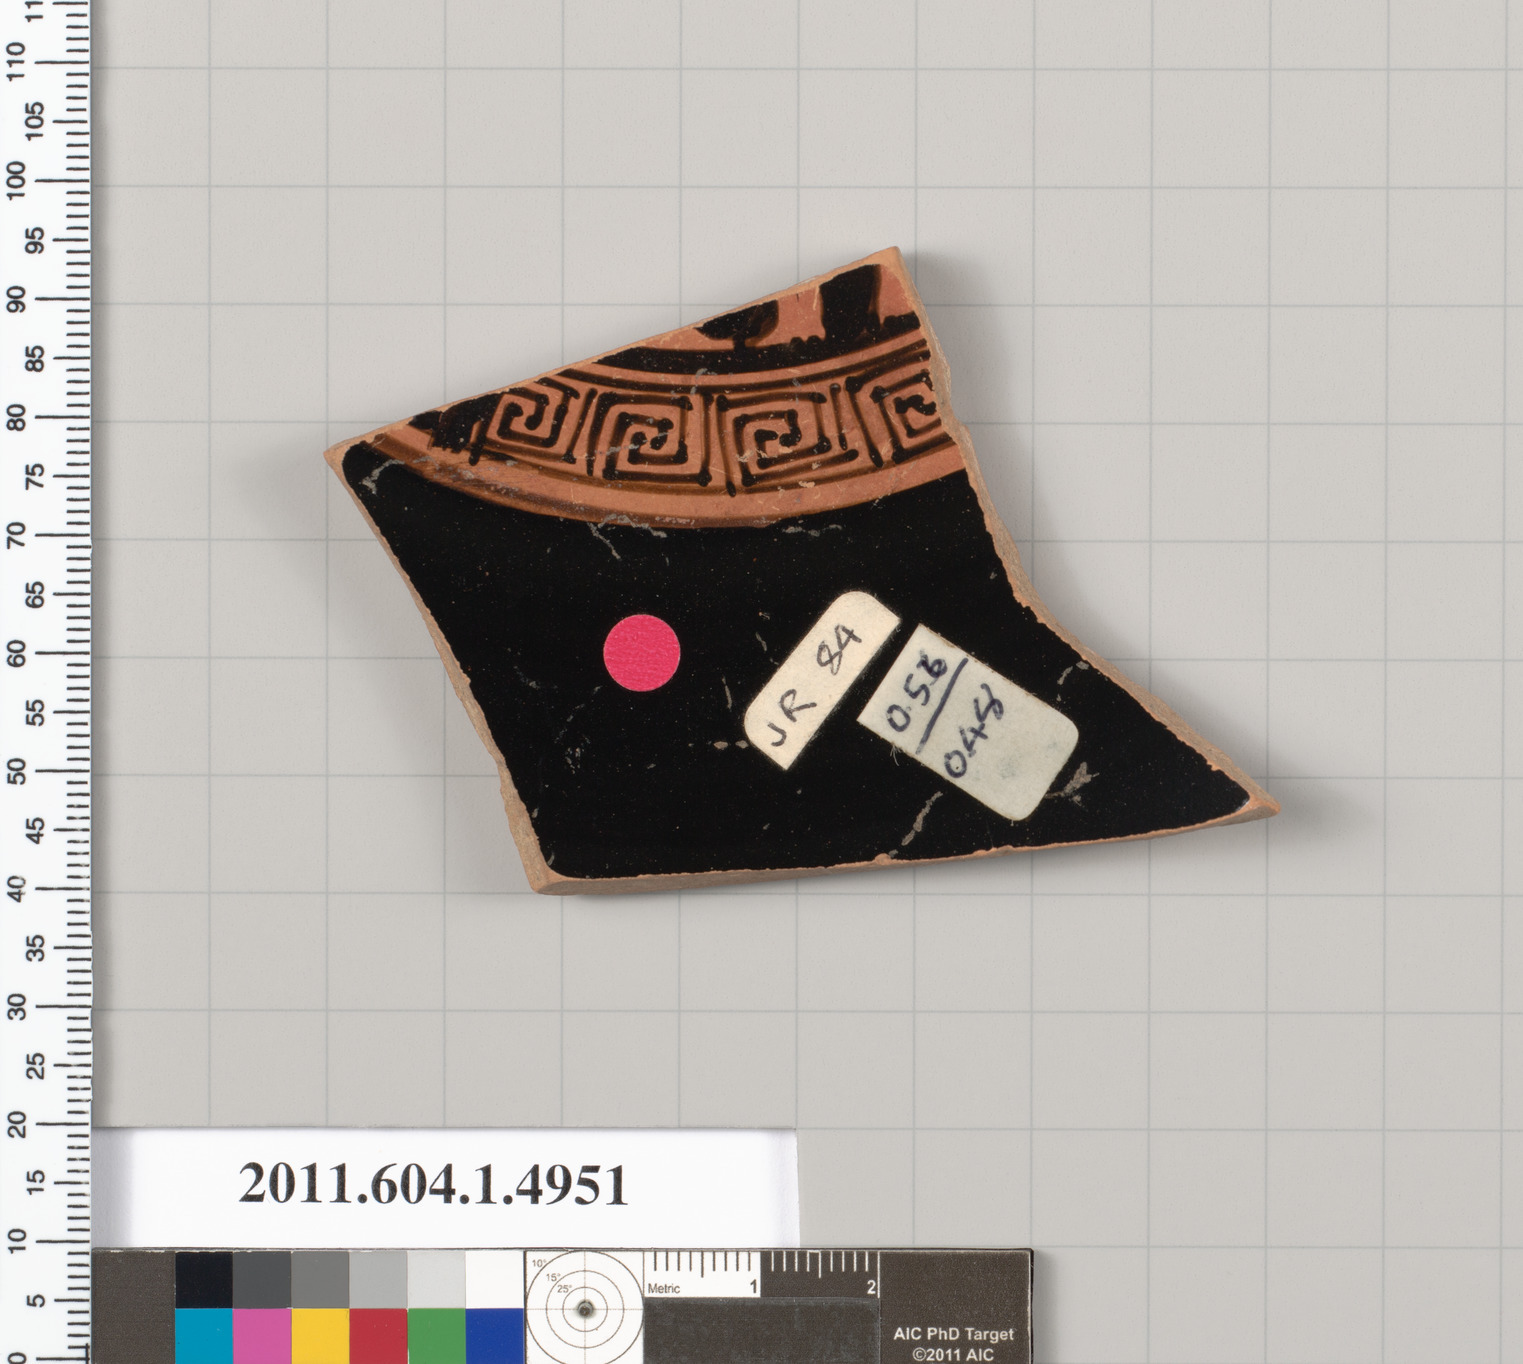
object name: kylix fragment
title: Terracotta fragment of a kylix (drinking cup)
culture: greek, attic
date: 467-435 BCE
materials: terracotta